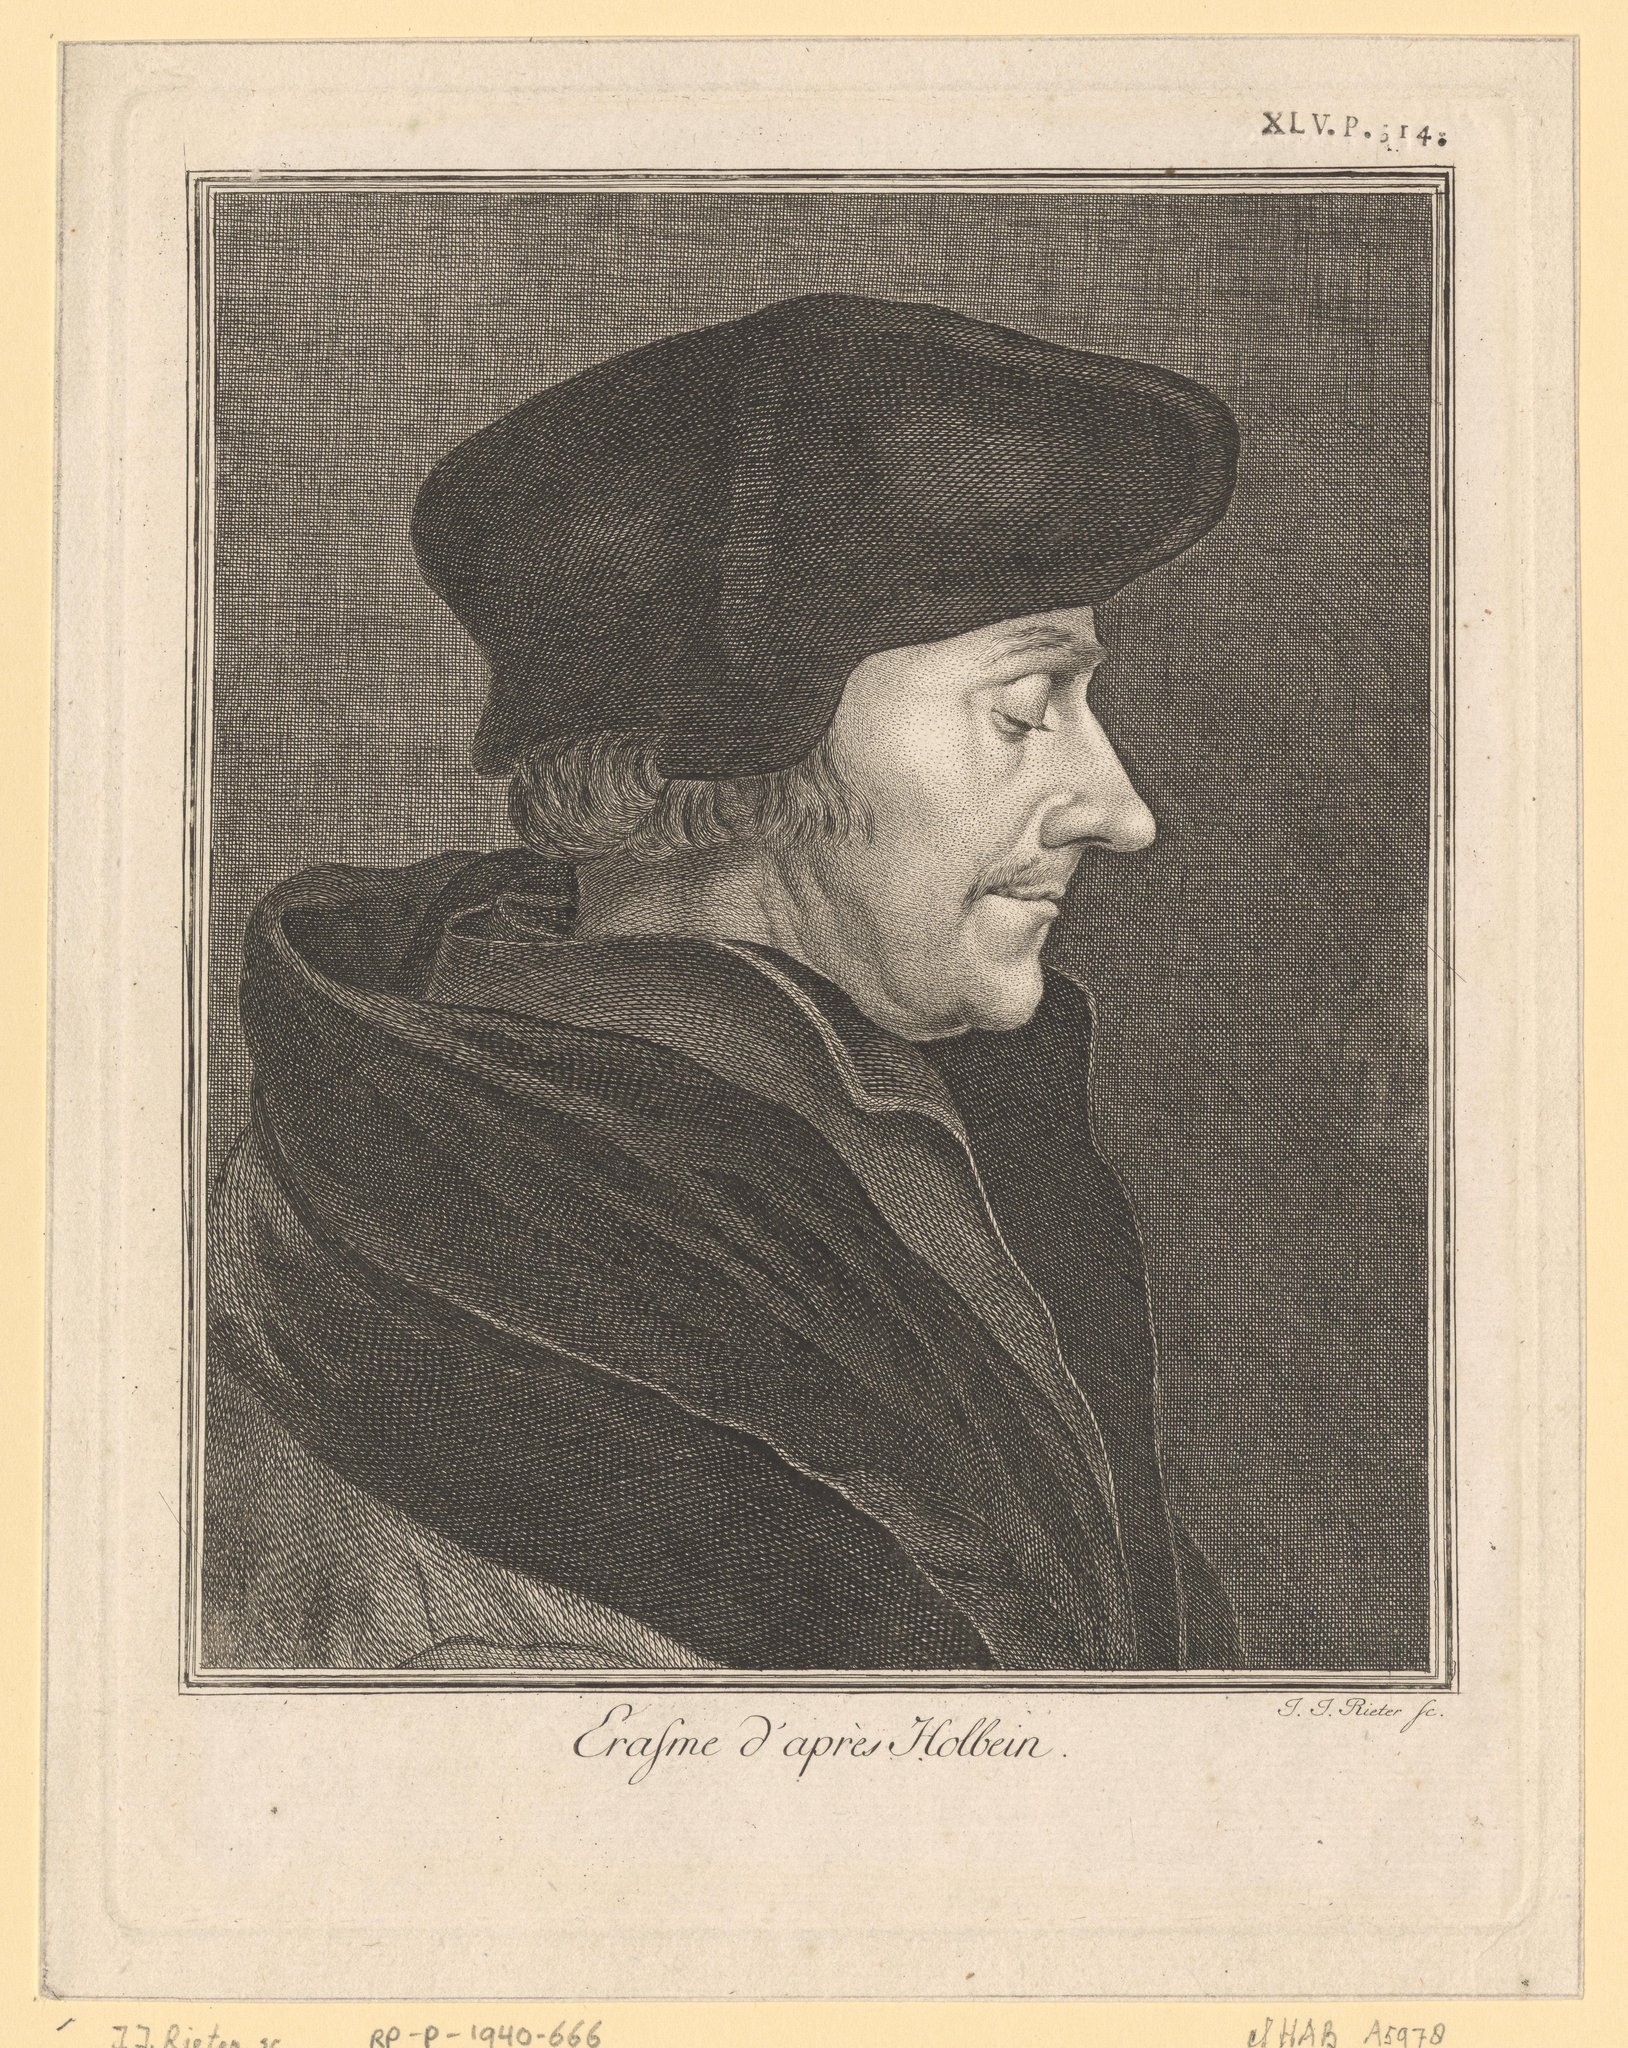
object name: print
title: Portret van Desiderius Erasmus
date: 1768-1823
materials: paper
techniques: engraving, etching, letterpress printing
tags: rotterdam, desiderius erasmus, historical persons, scholar, philosopher (+ portrait of scholar, scientist)